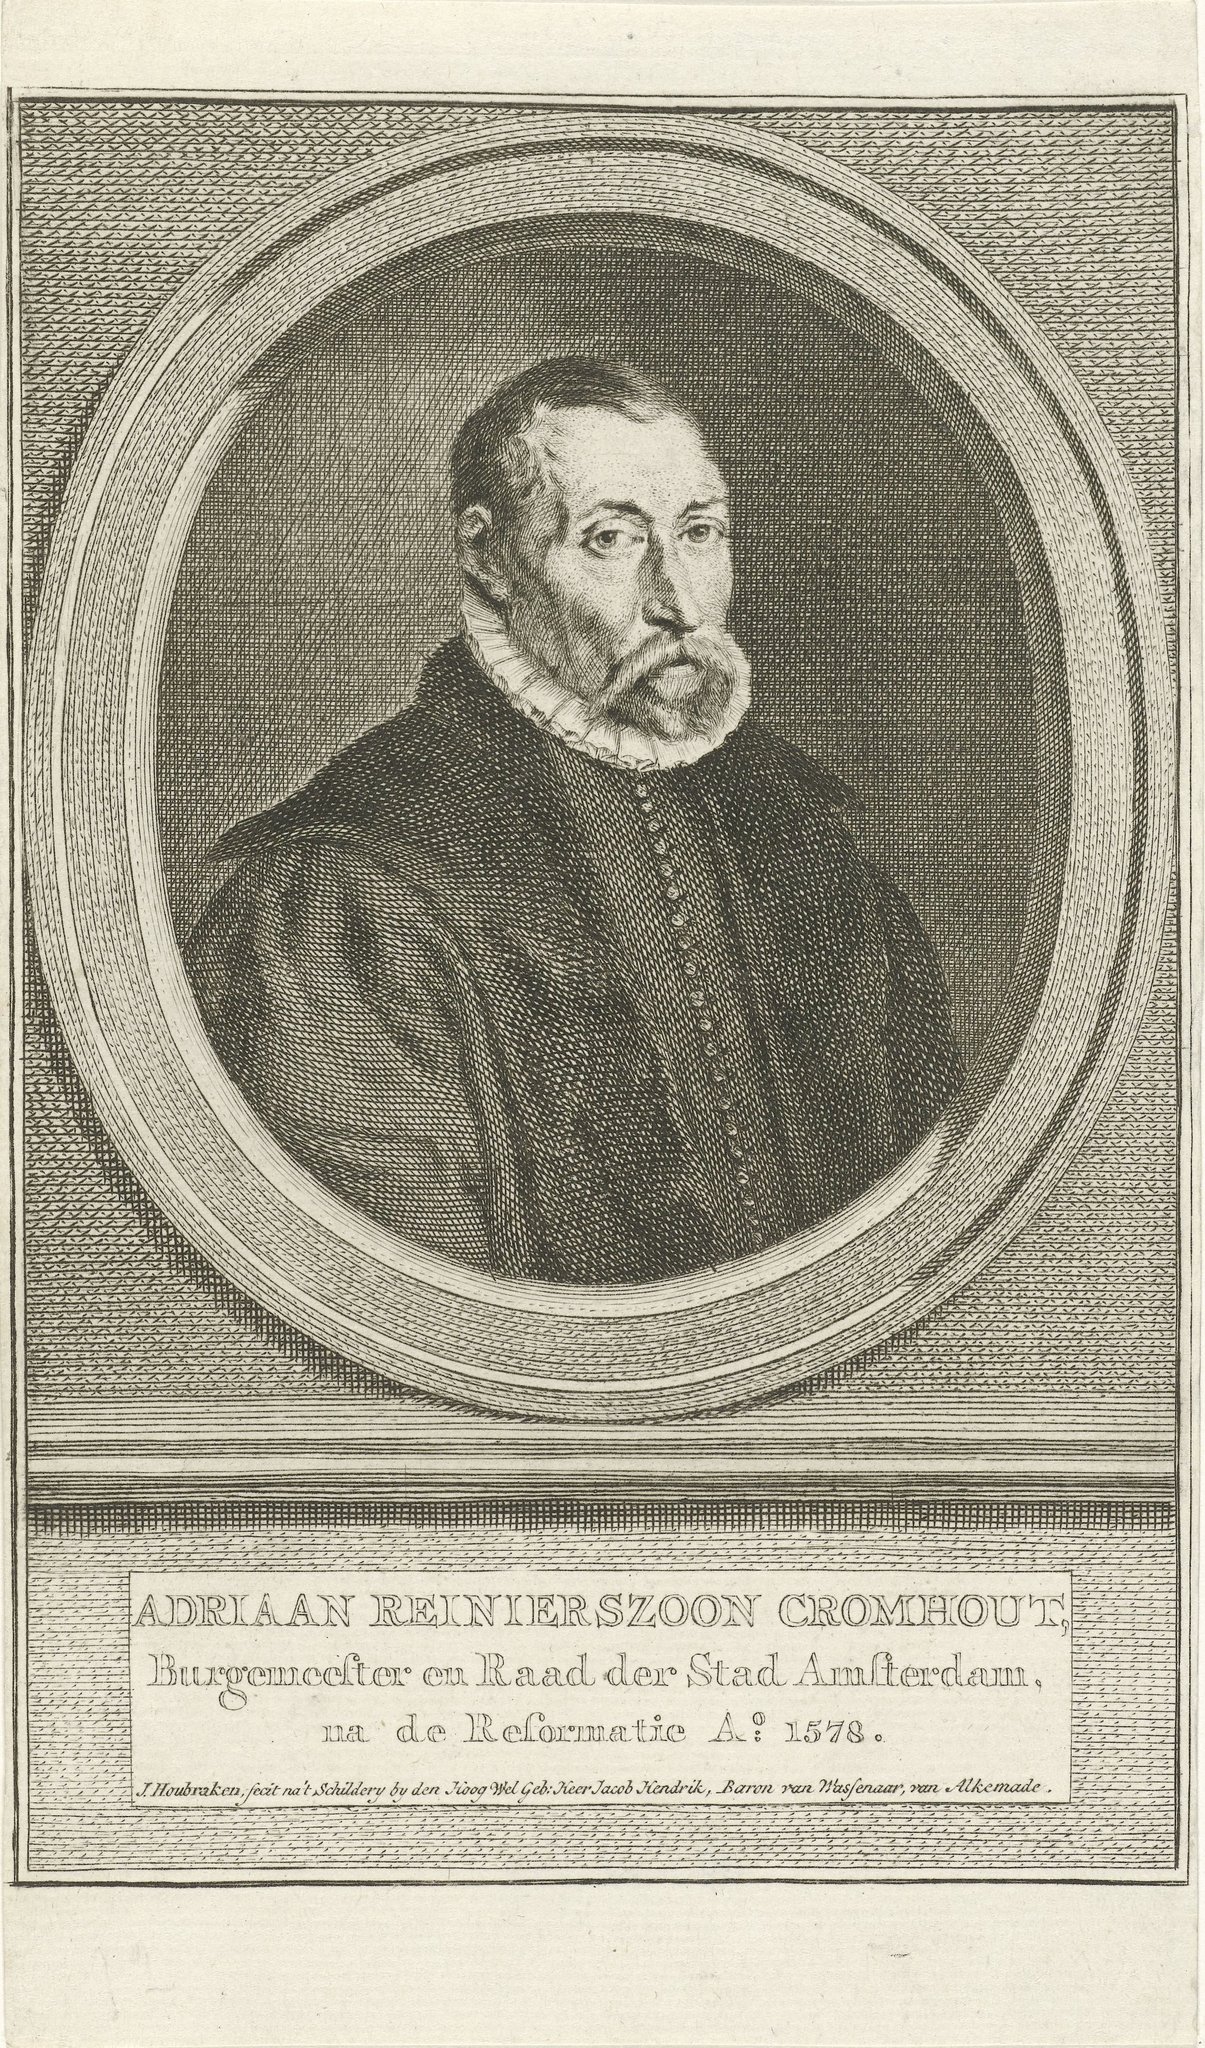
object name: print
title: Adriaan Reinierszoon Cromhout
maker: jacob houbraken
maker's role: draughtsman, print maker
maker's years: 1698-1780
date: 1749-1759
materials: paper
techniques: engraving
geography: amsterdam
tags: adriaan reinierszoon cromhout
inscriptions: collector's mark: Lugt 2228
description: Prent oorspronkelijk bedoeld voor: Jan Wagenaar, Vaderlandsche historie, vervattende de geschiedenissen der nu Vereenigde Nederlanden, inzonderheid die van Holland (...), 21 delen. Amsterdam, Isaak Tirion, 1749-59.